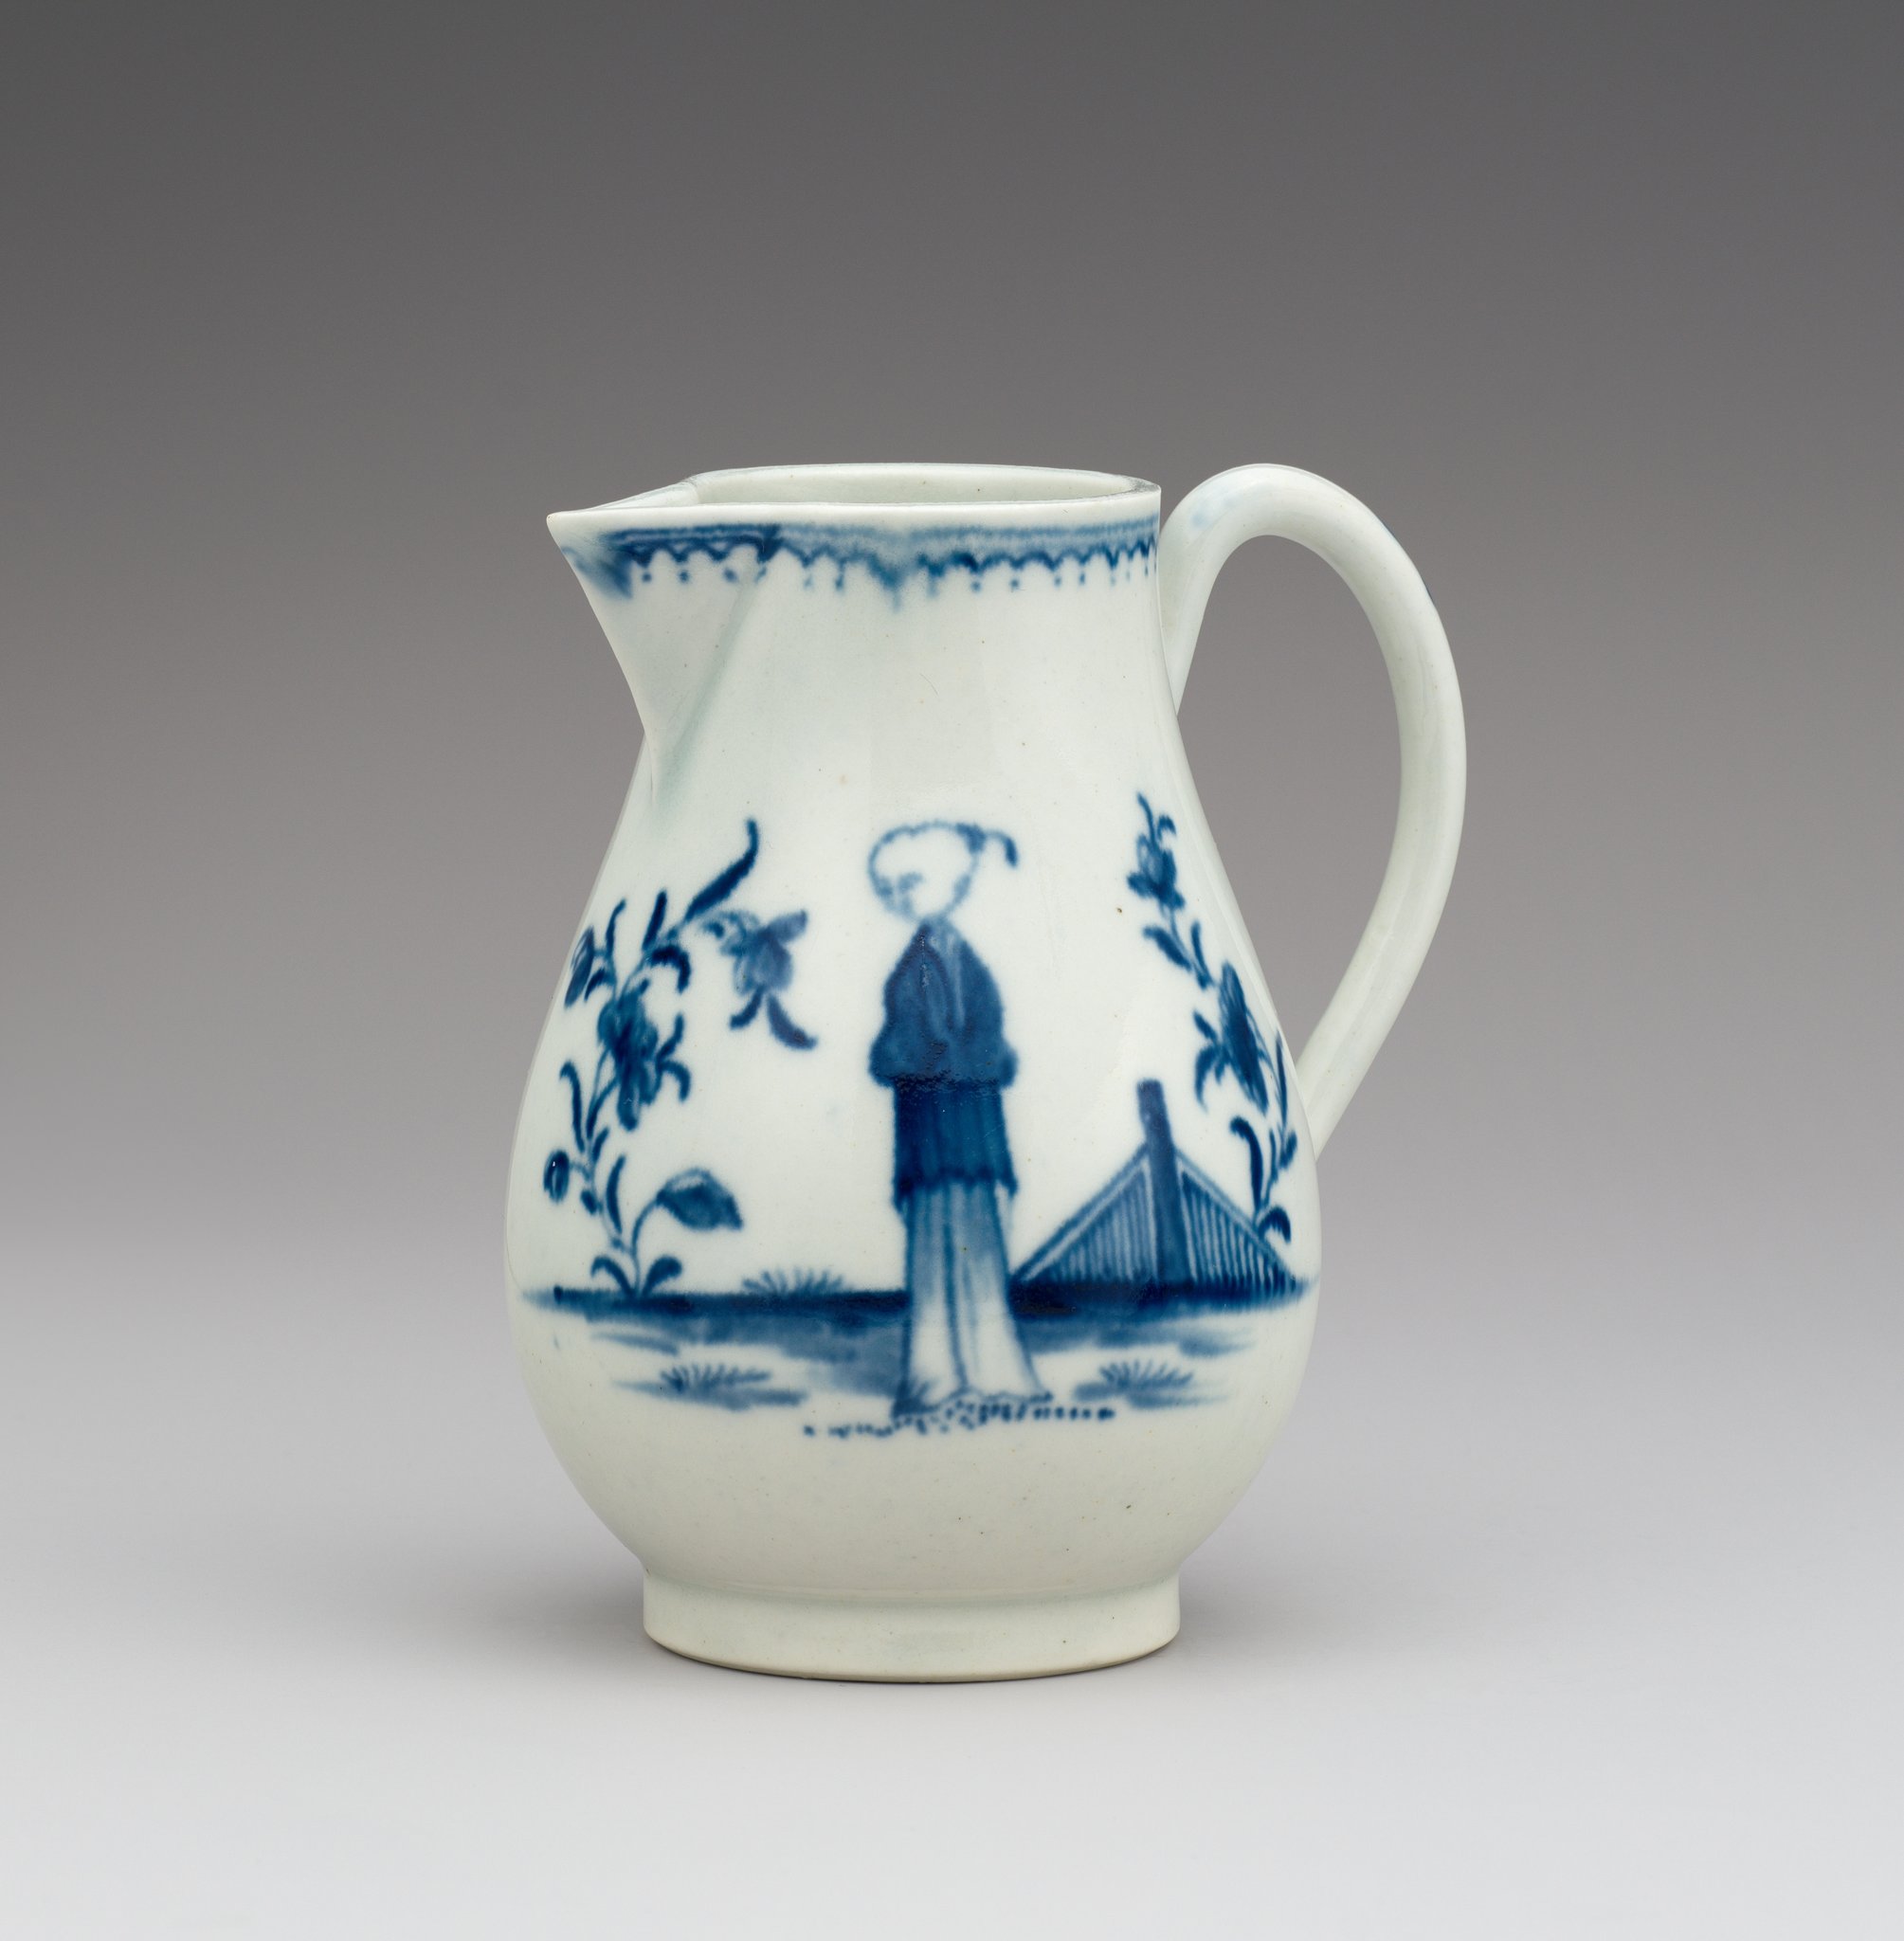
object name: cream pitcher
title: Cream pitcher (part of a service)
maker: worcester factory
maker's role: factory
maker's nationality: british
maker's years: 1751-2008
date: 1760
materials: soft paste porcelain